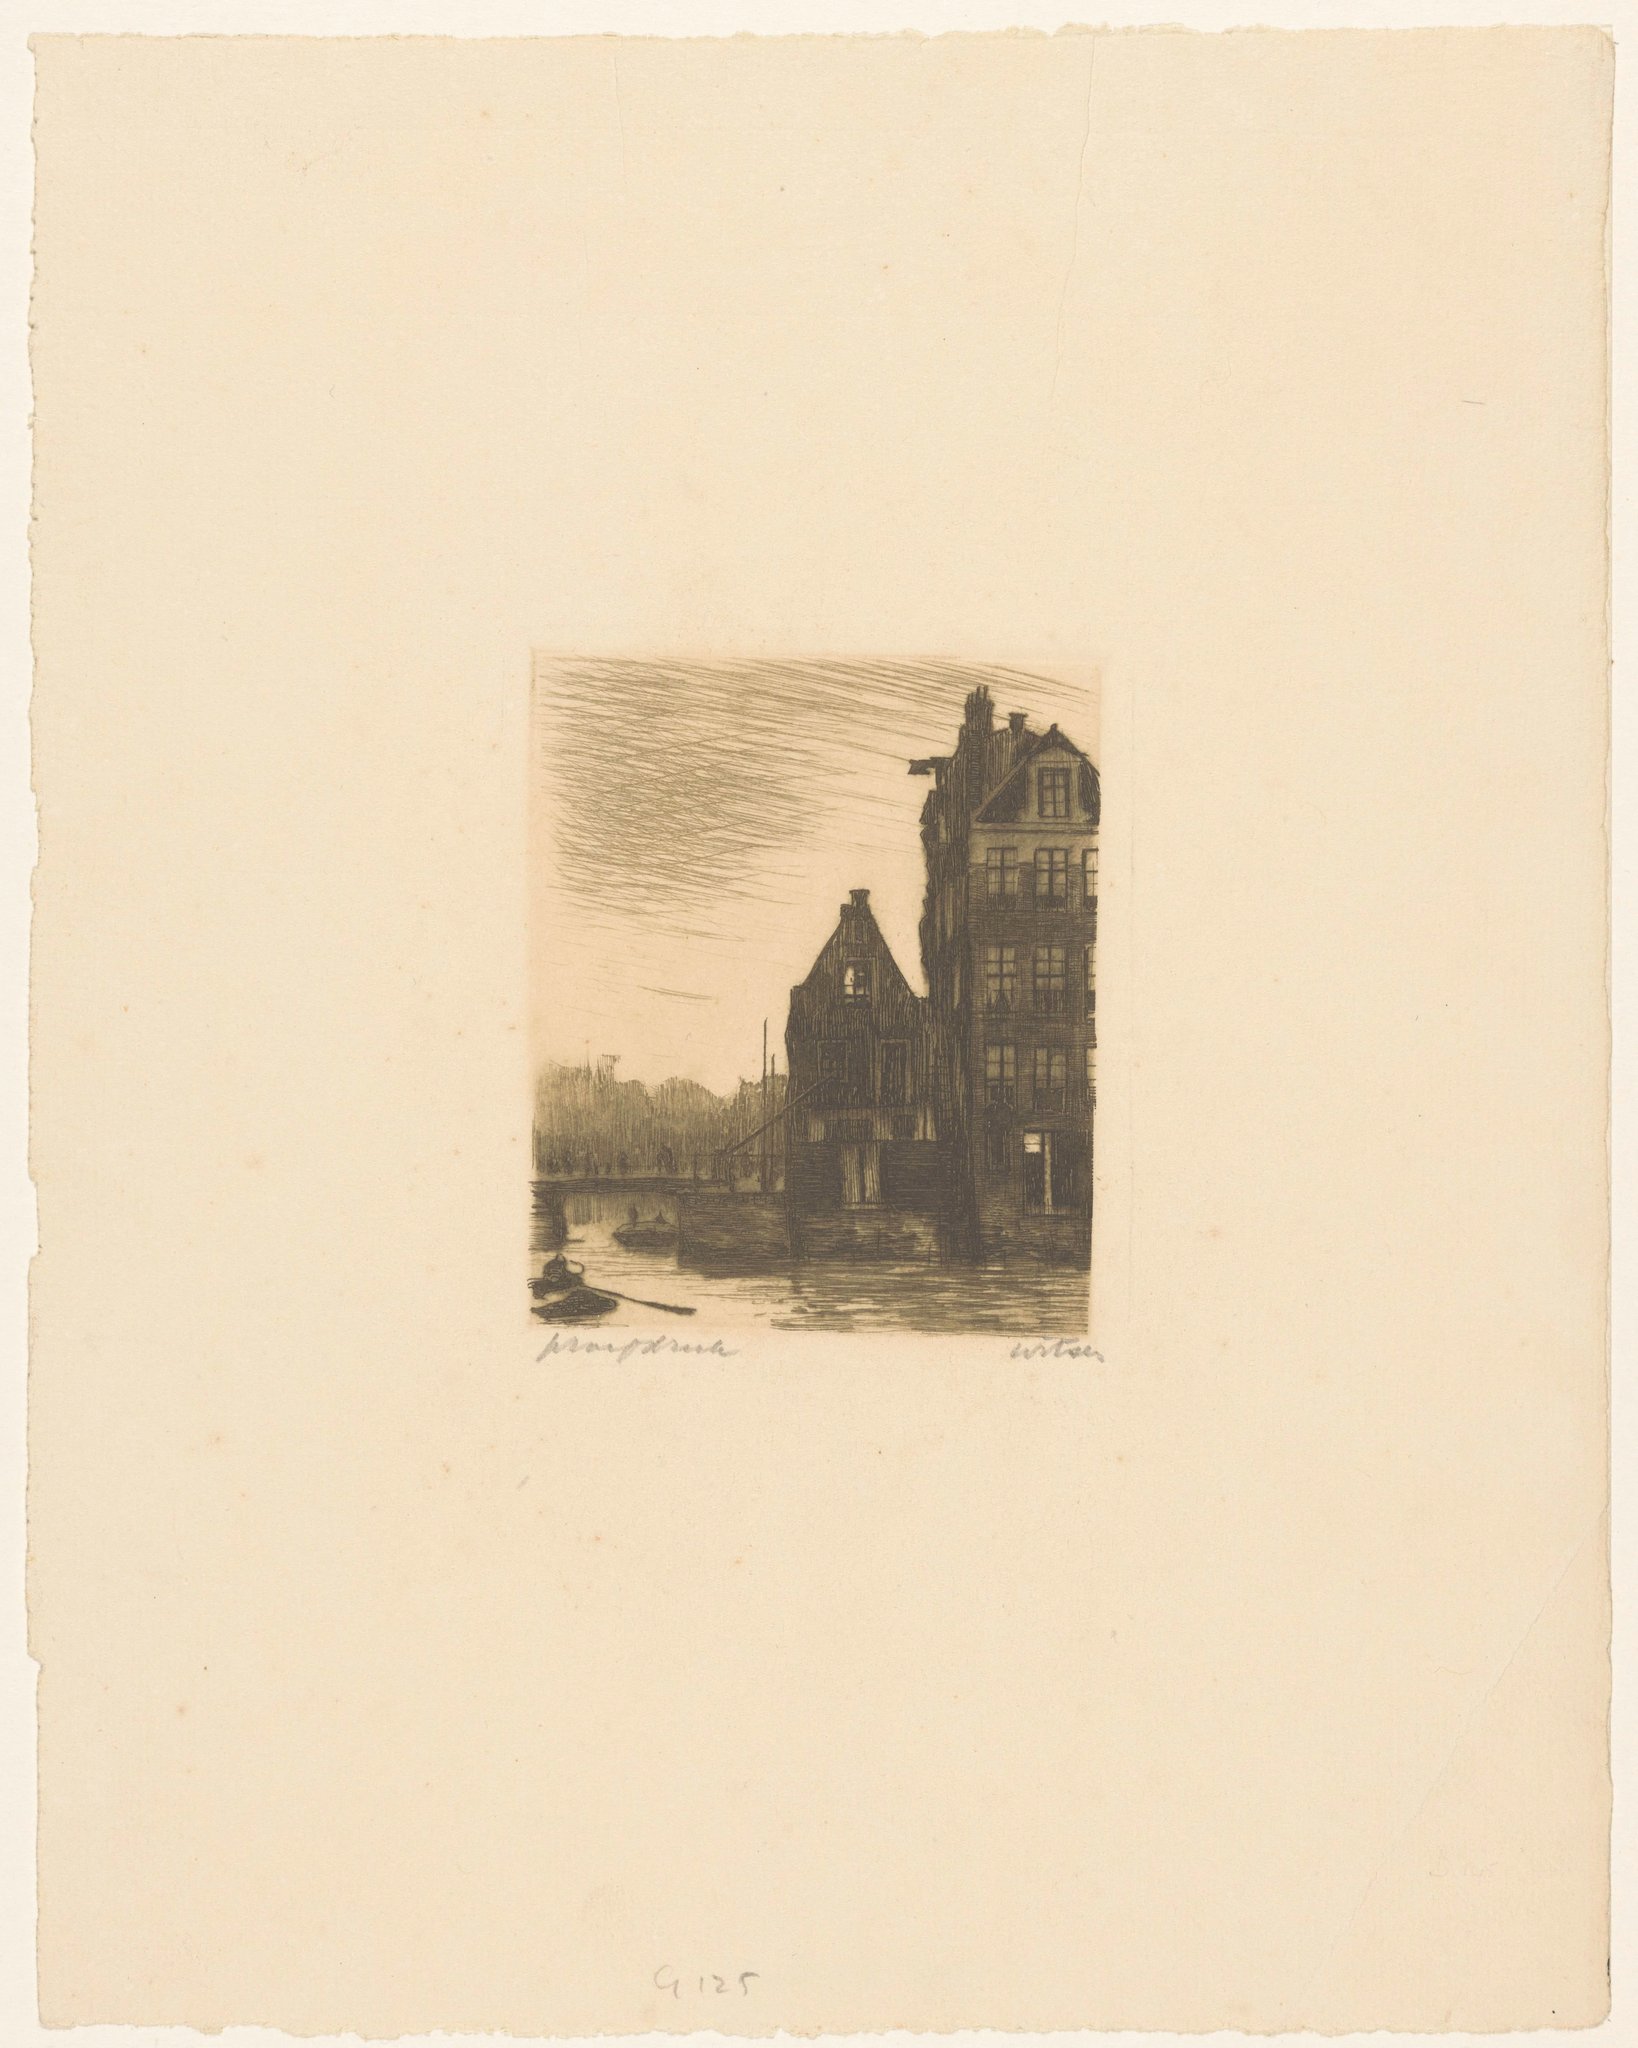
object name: print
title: Gezicht op de Sint Antoniesluis in Amsterdam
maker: willem witsen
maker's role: draughtsman, painter, print maker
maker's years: 1860-1923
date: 1911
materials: paper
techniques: etching, intaglio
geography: amsterdam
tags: canals, waters (in city), bridge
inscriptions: inscription: ‘proefdruk’, signature: ‘Witsen’, watermark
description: Gezien vanaf de Oude Schans richting de Zwanenburgwal.